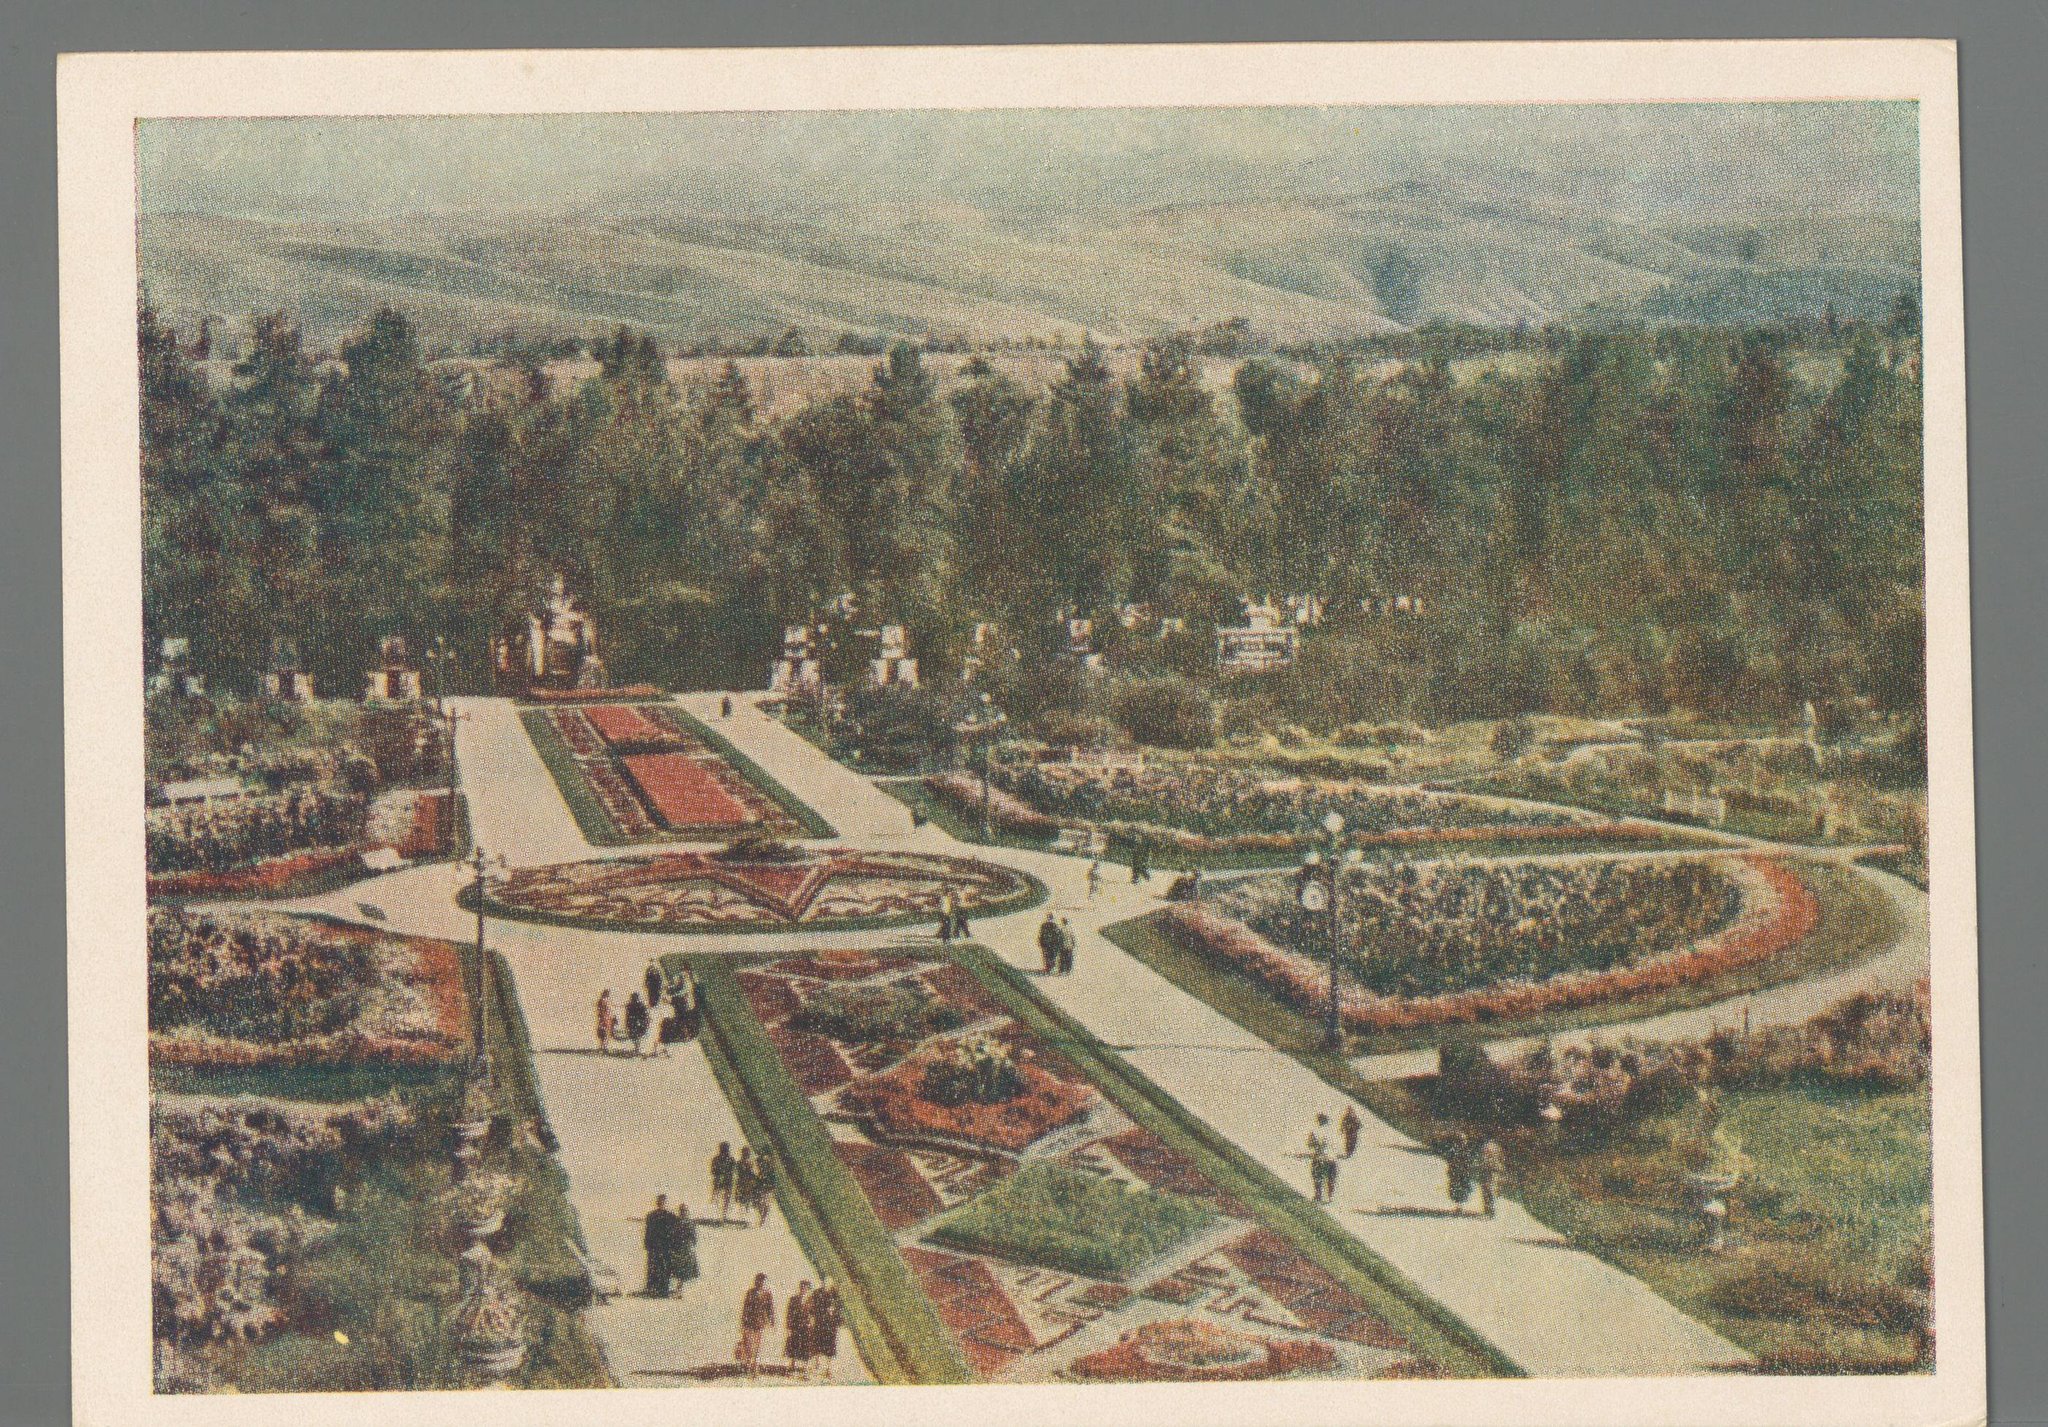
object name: ansichtkaart, prentbriefkaart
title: Kazakh S.S.R. Alma-Ata. Gorky Recreation Park / R.S.S. de Kazakhie. Alma-Ata. Parc de culture et de repos Gorki / Kasachische SSR. Alma-Ata. Gorki-Park für Kultur und Erholung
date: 1956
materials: cardboard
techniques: color autotype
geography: alma-ata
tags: park, mountains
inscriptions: date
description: De titel op object staat ook in het Russisch.